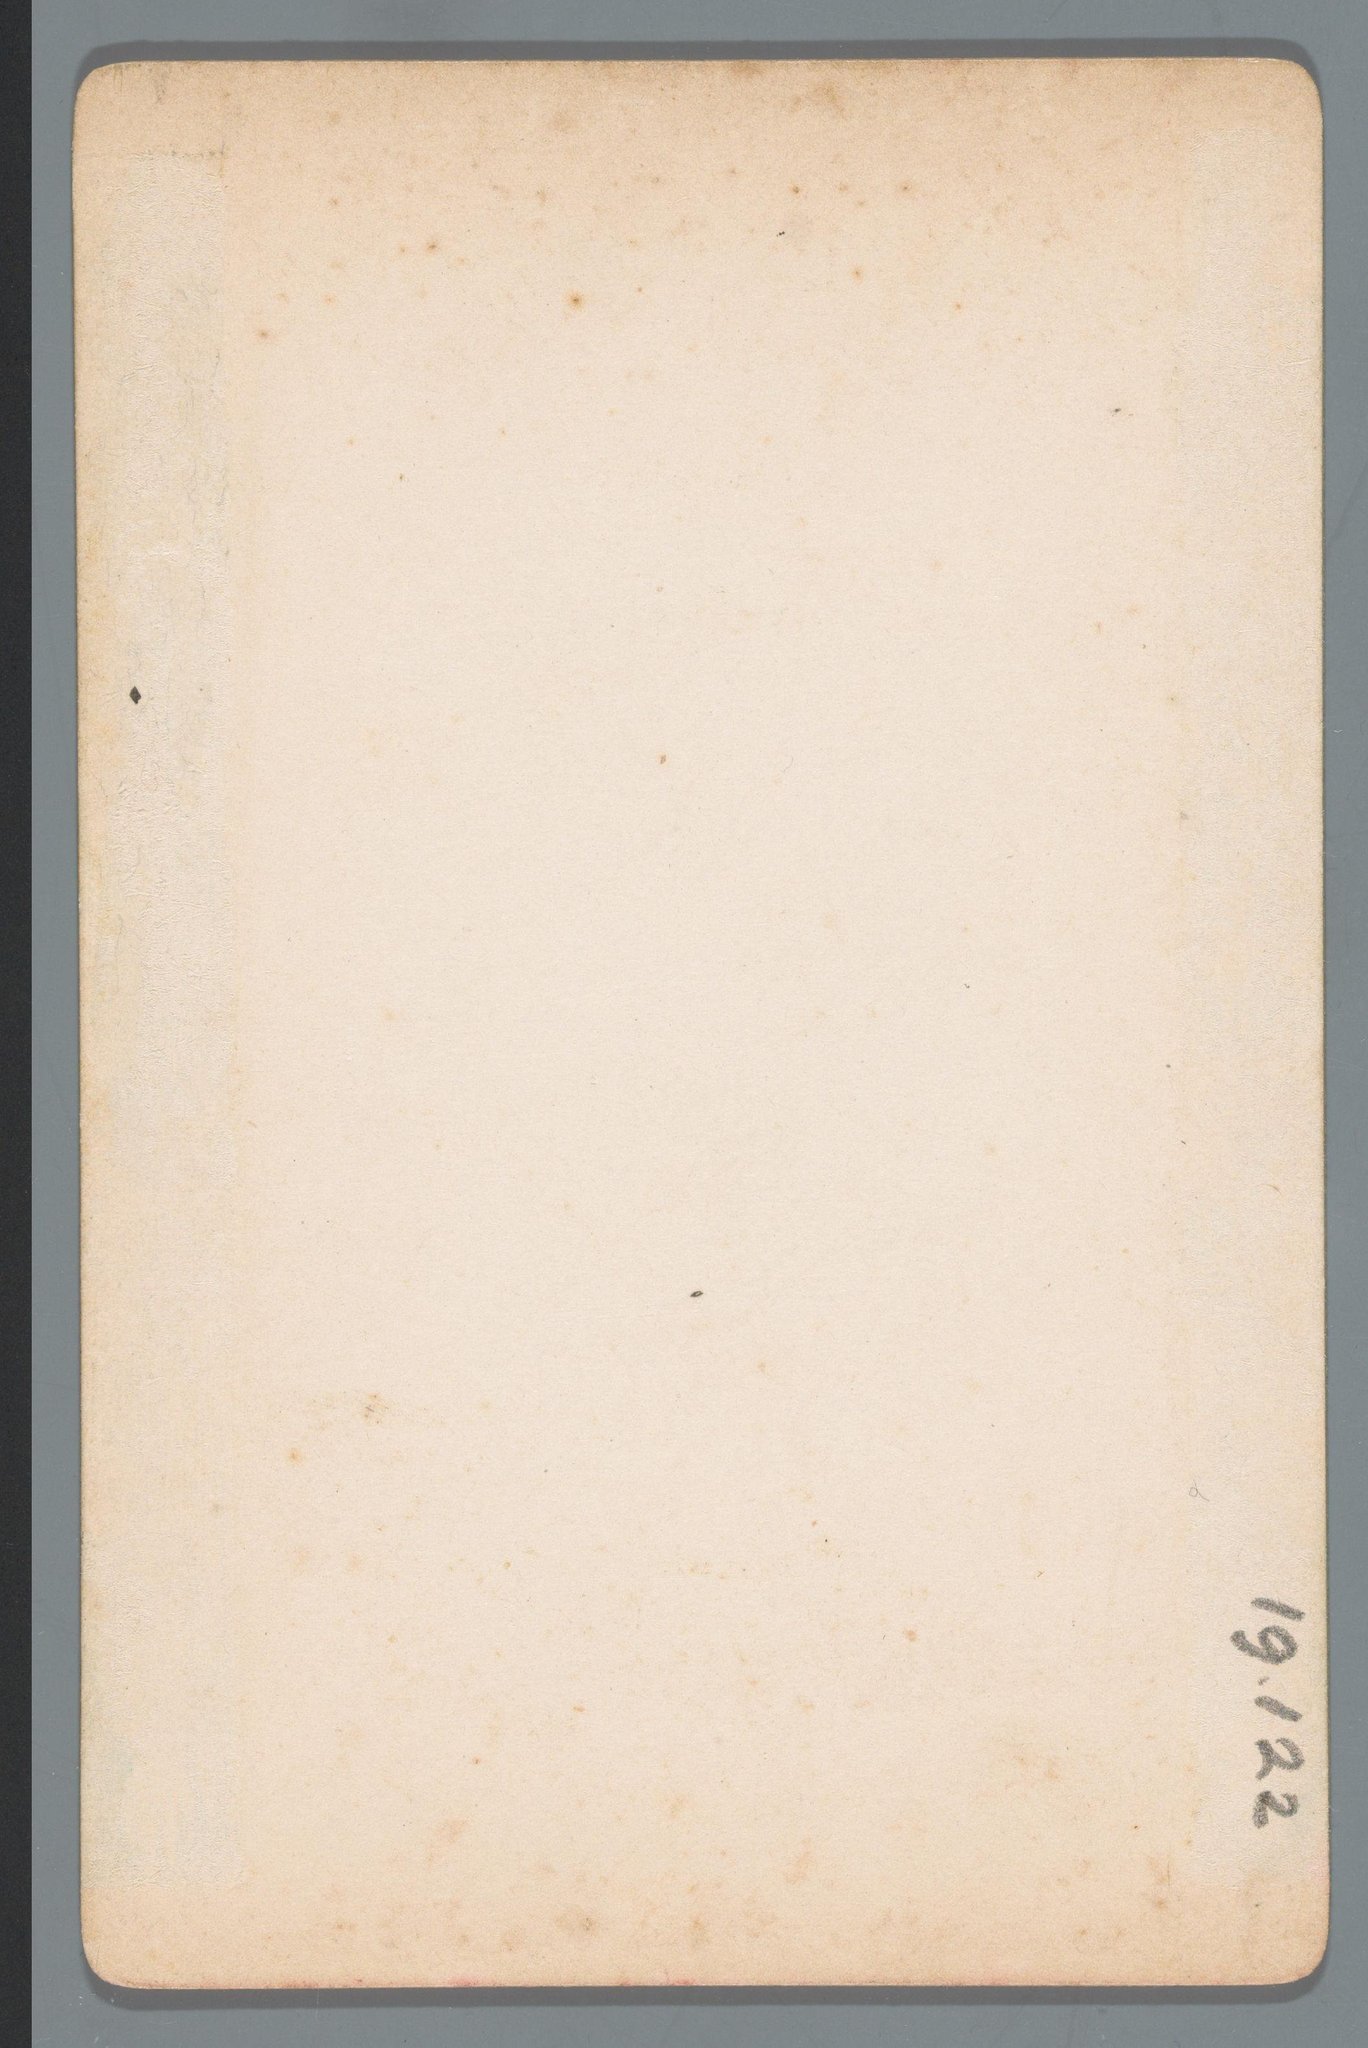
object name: photograph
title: Gezicht op het strand van Scheveningen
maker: Anonymous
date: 1870-1890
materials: cardboard, photographic support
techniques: albumen print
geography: scheveningen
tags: beach (as place of recreation)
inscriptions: number: ‘16’